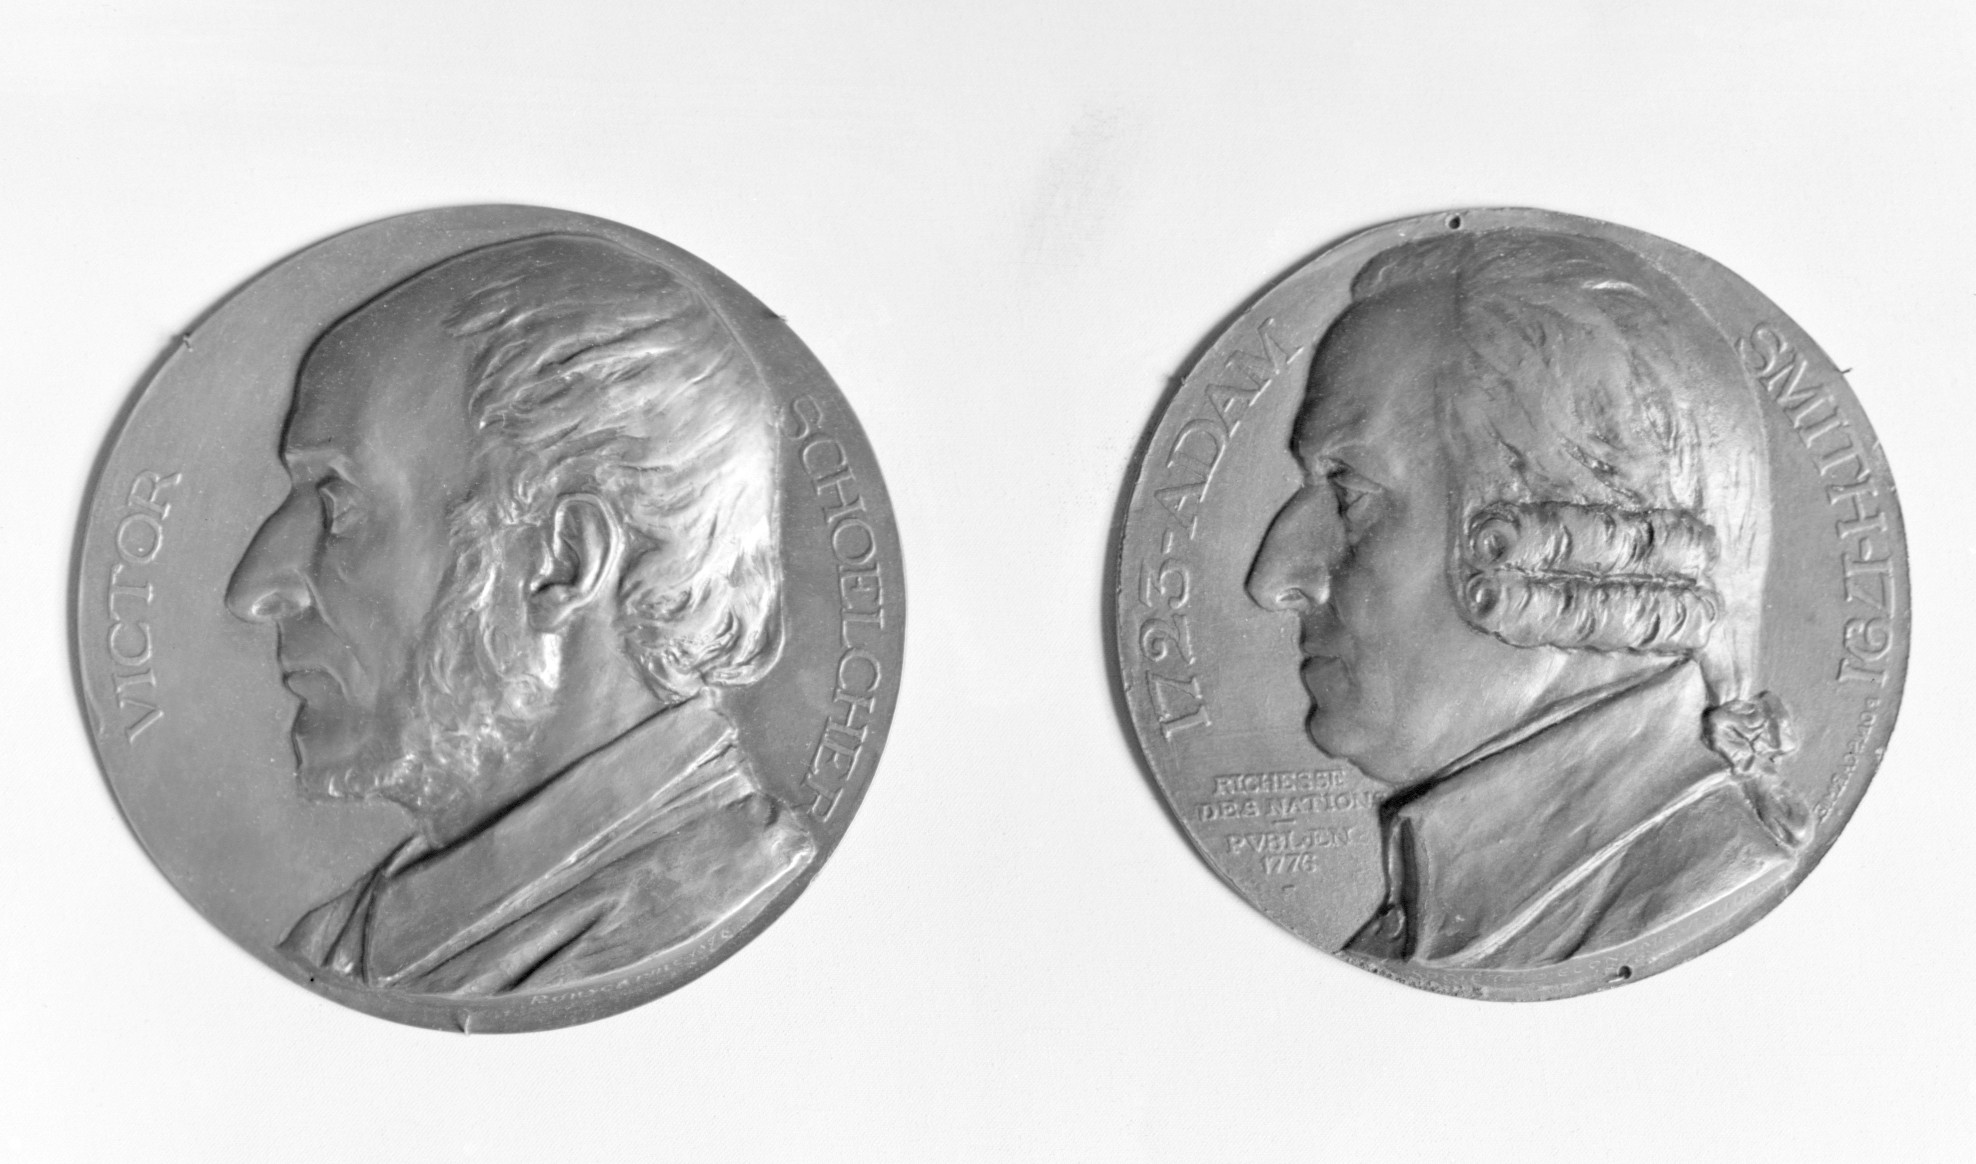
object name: medallion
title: Victor Schoelcher, Journalist and Author, 1878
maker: françois-joseph-hubert ponscarme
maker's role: artist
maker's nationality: french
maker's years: 1827-1903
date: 1878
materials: bronze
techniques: casting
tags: men,profiles